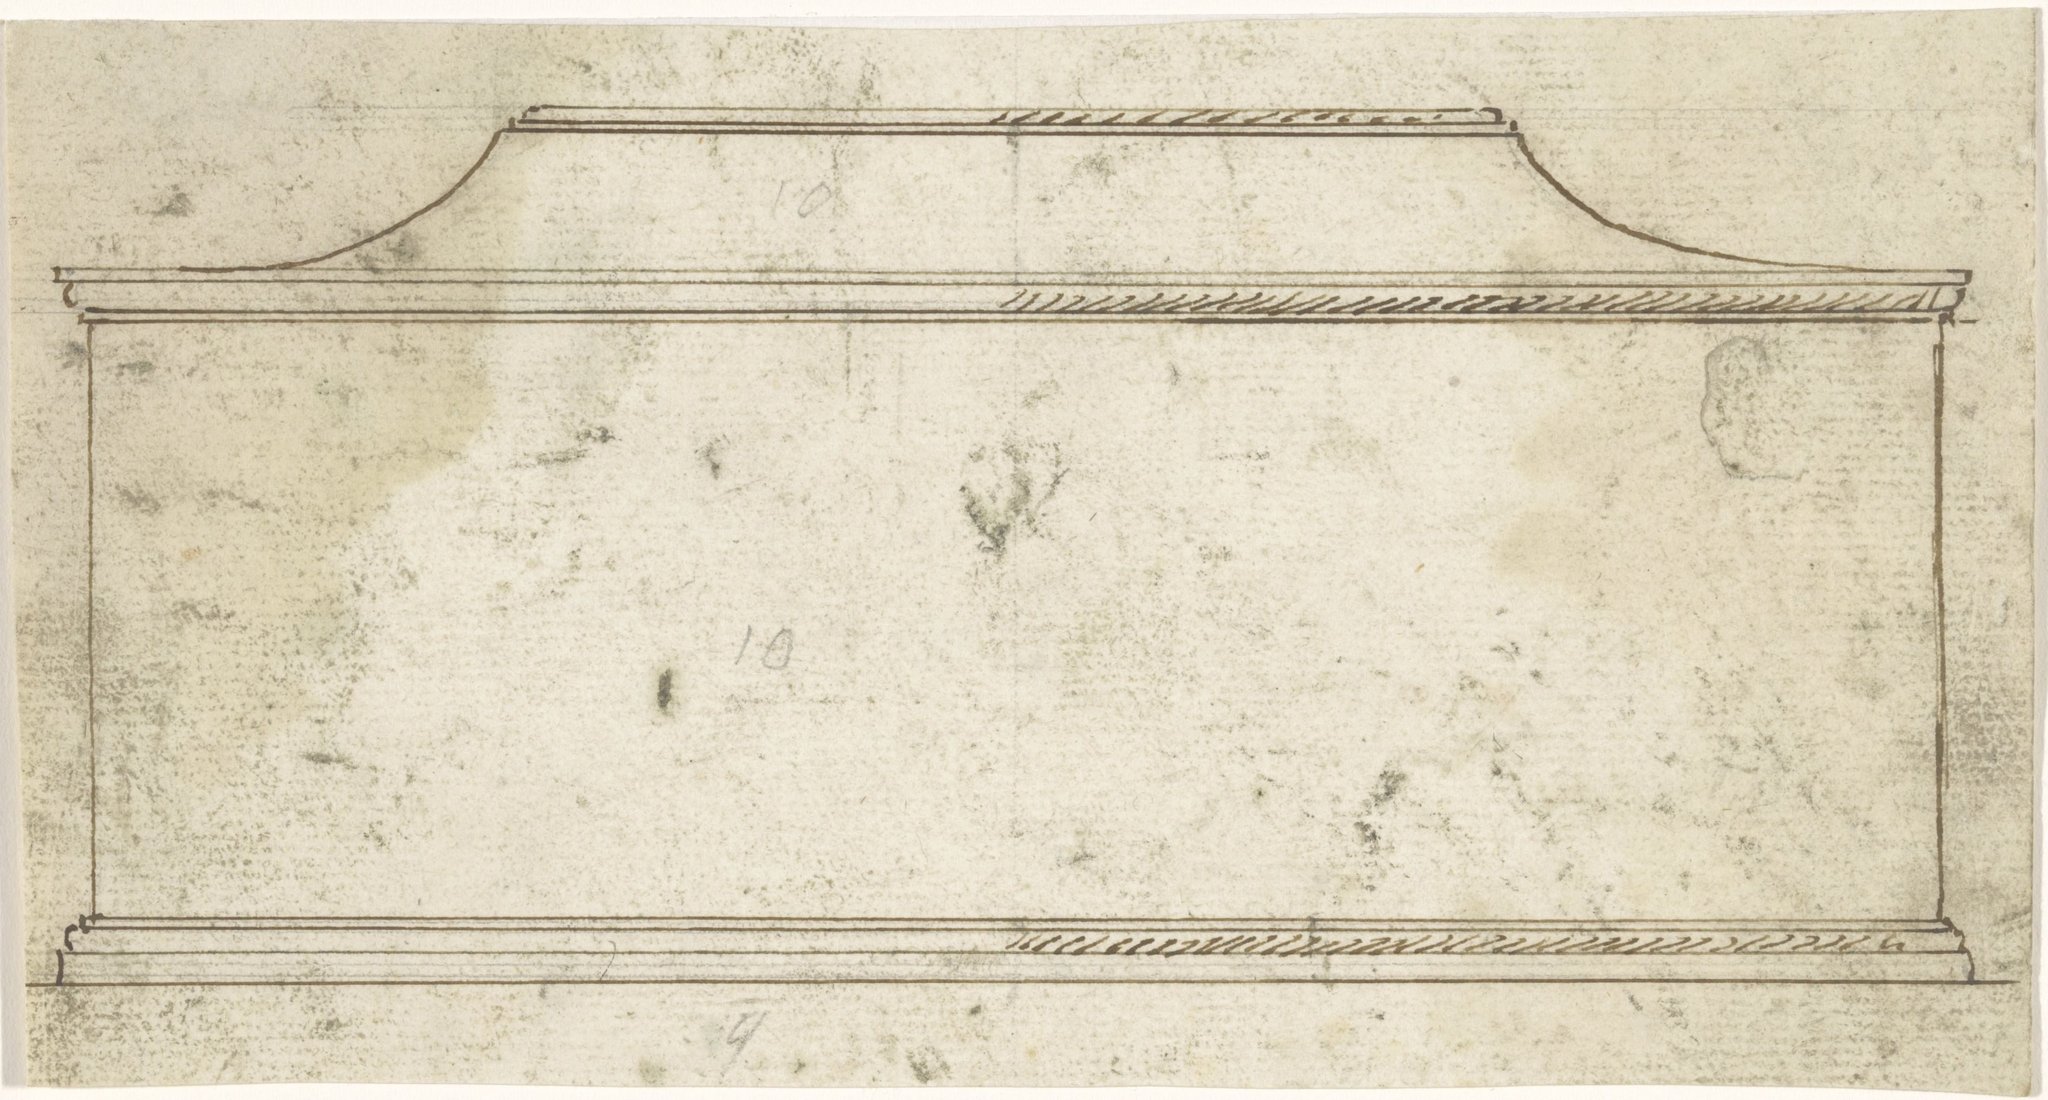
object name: design drawing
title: Ontwerp voor een dekseldoos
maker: luigi valadier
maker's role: draughtsman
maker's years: 1726-1785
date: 1760-1780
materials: graphite, ink, paper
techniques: pen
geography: rome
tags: containers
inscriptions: watermark, inscription: ‘10 en 4 [?]’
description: Ontwerp voor een dekseldoos, de rechterhelft met meer details dan de linkerhelft.